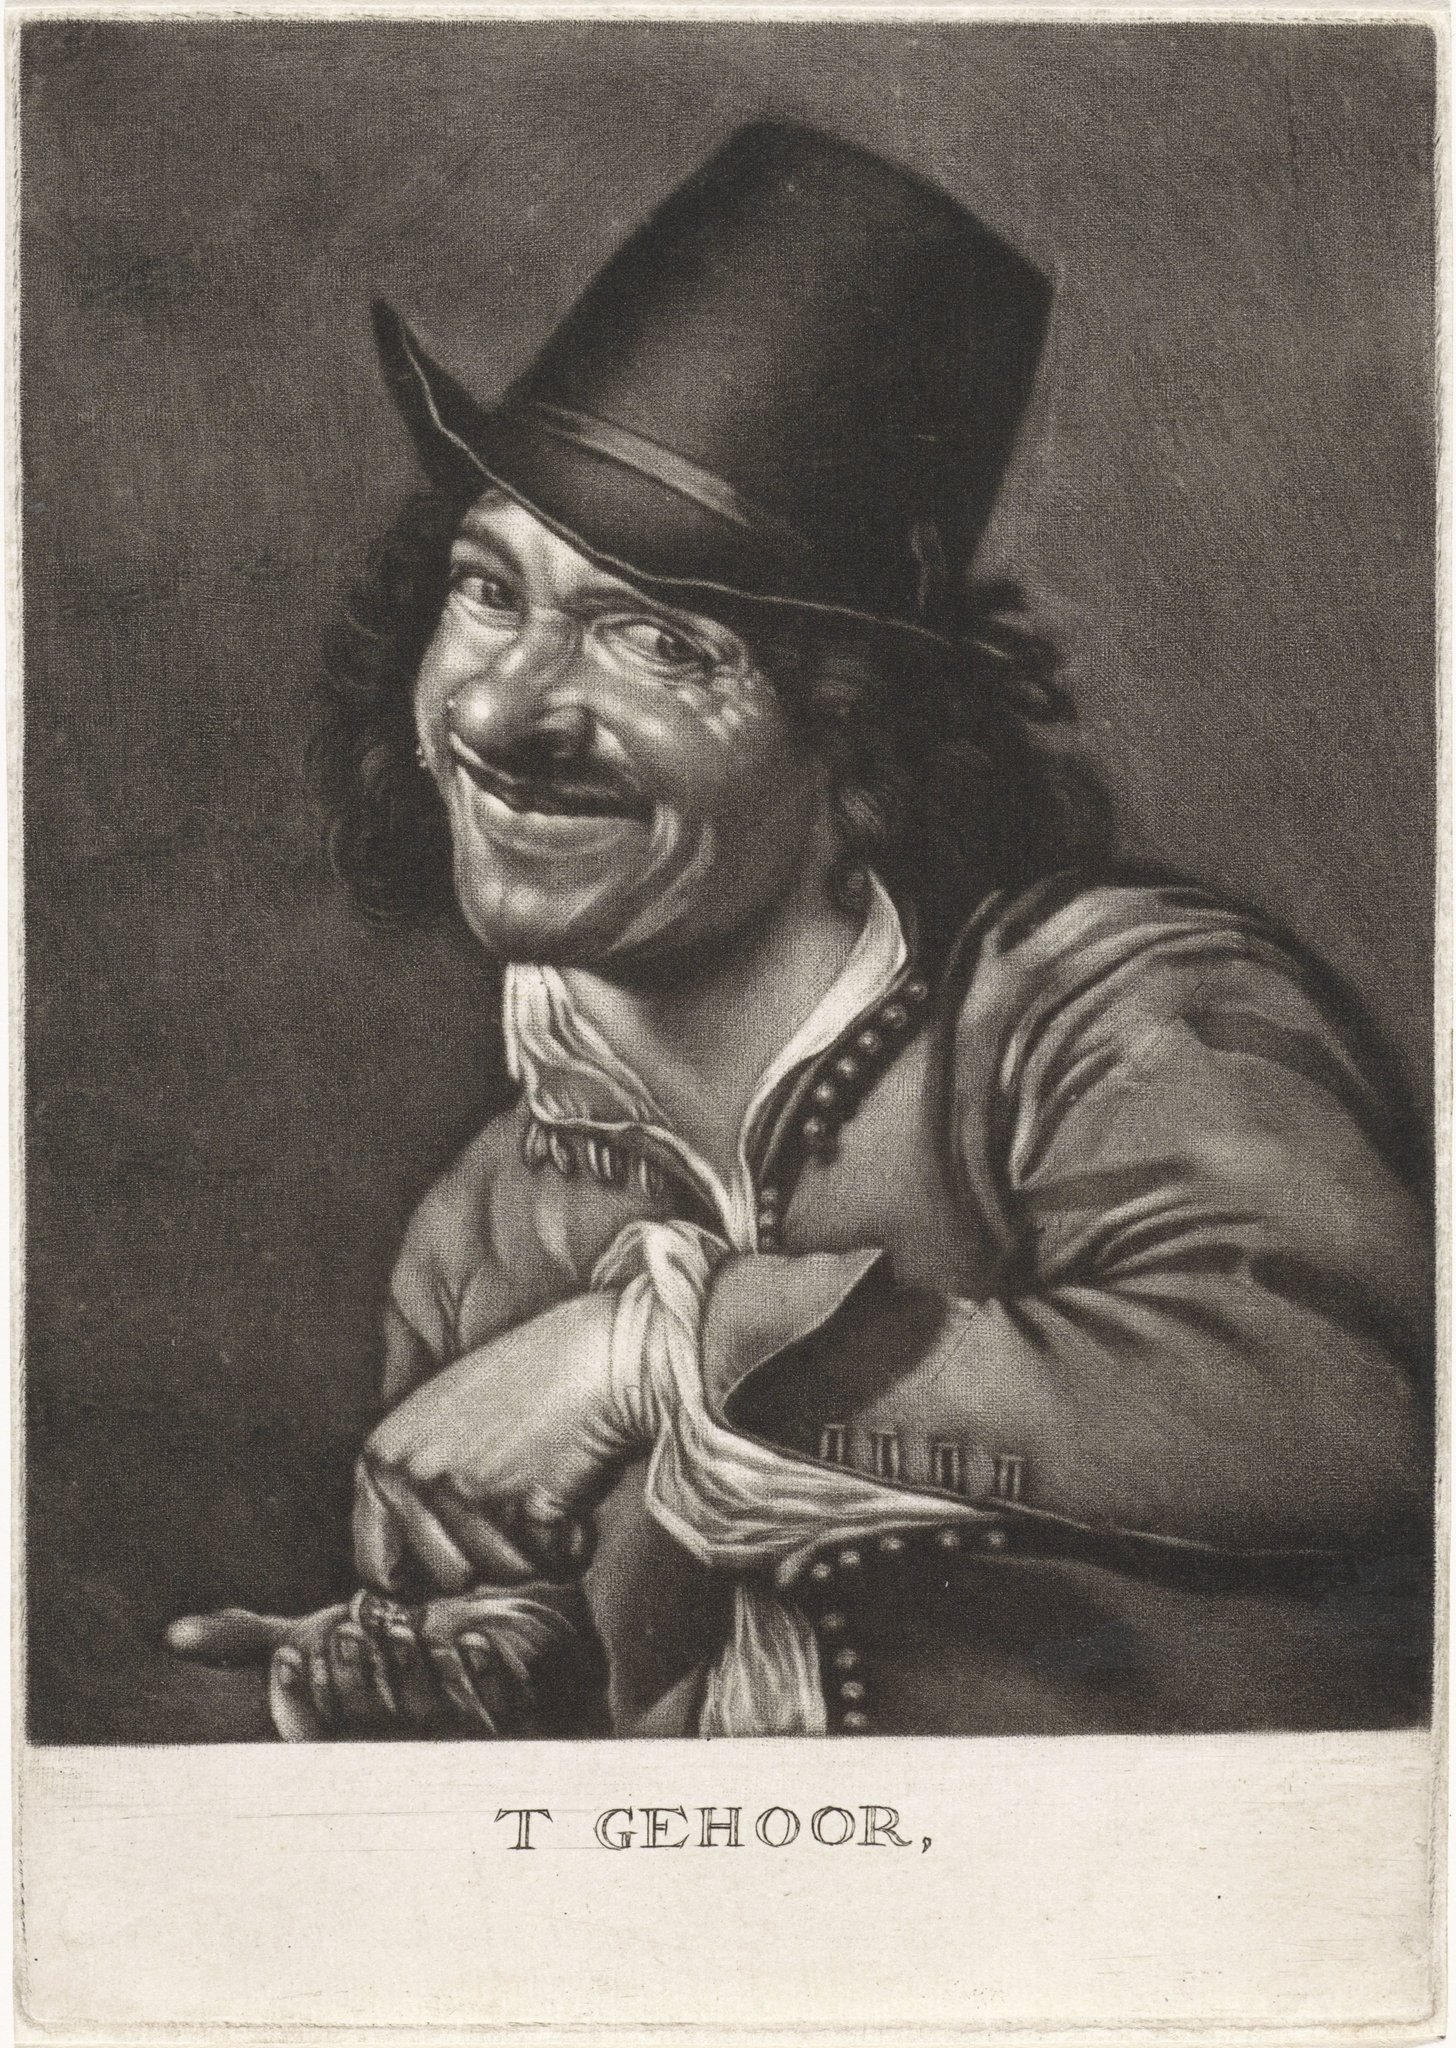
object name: print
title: De vijf zintuigen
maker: pieter schenk (i)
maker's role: print maker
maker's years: 1660-1711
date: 1670-1713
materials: paper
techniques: mezzotint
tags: hearing, listening (one of the five senses), money-changer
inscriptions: collector's mark: Lugt 2228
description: Het Gehoor. Een man met een hoed op telt geldstukken. De prent maakt deel uit van een serie met de vijf zintuigen.